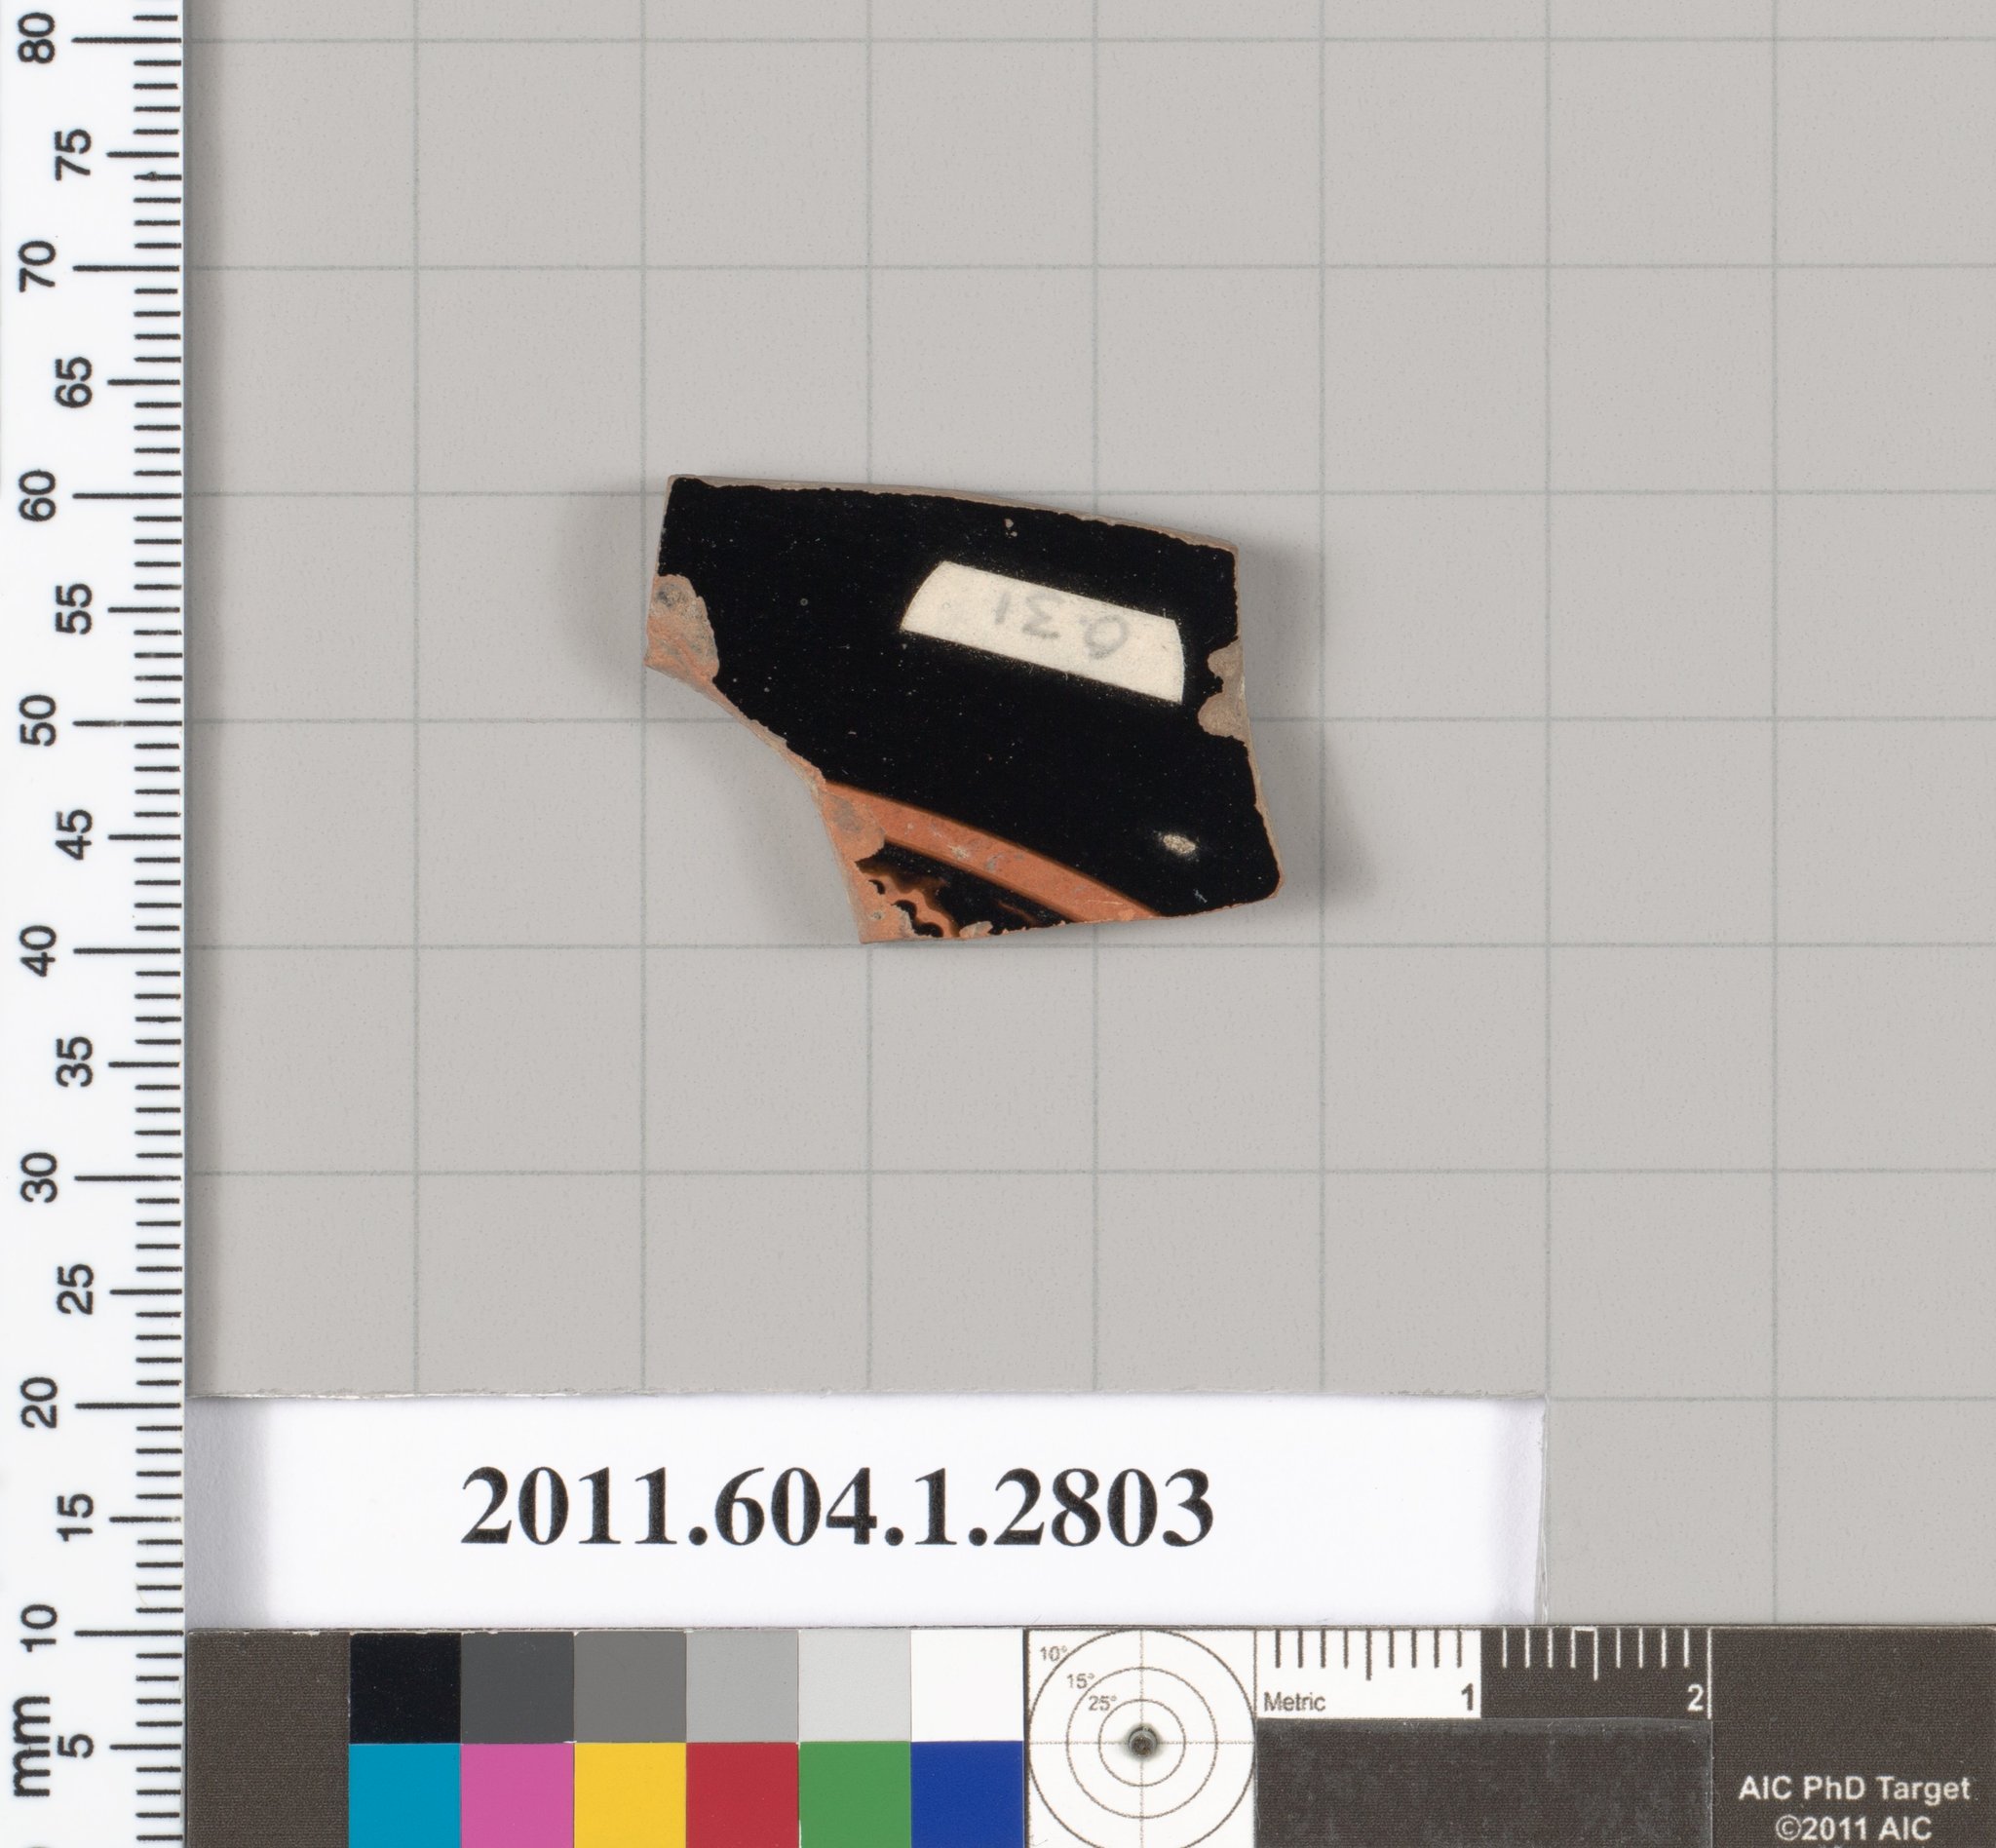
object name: kylix fragment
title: Terracotta fragment of a kylix (drinking cup)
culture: greek, attic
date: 520-500 BCE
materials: terracotta